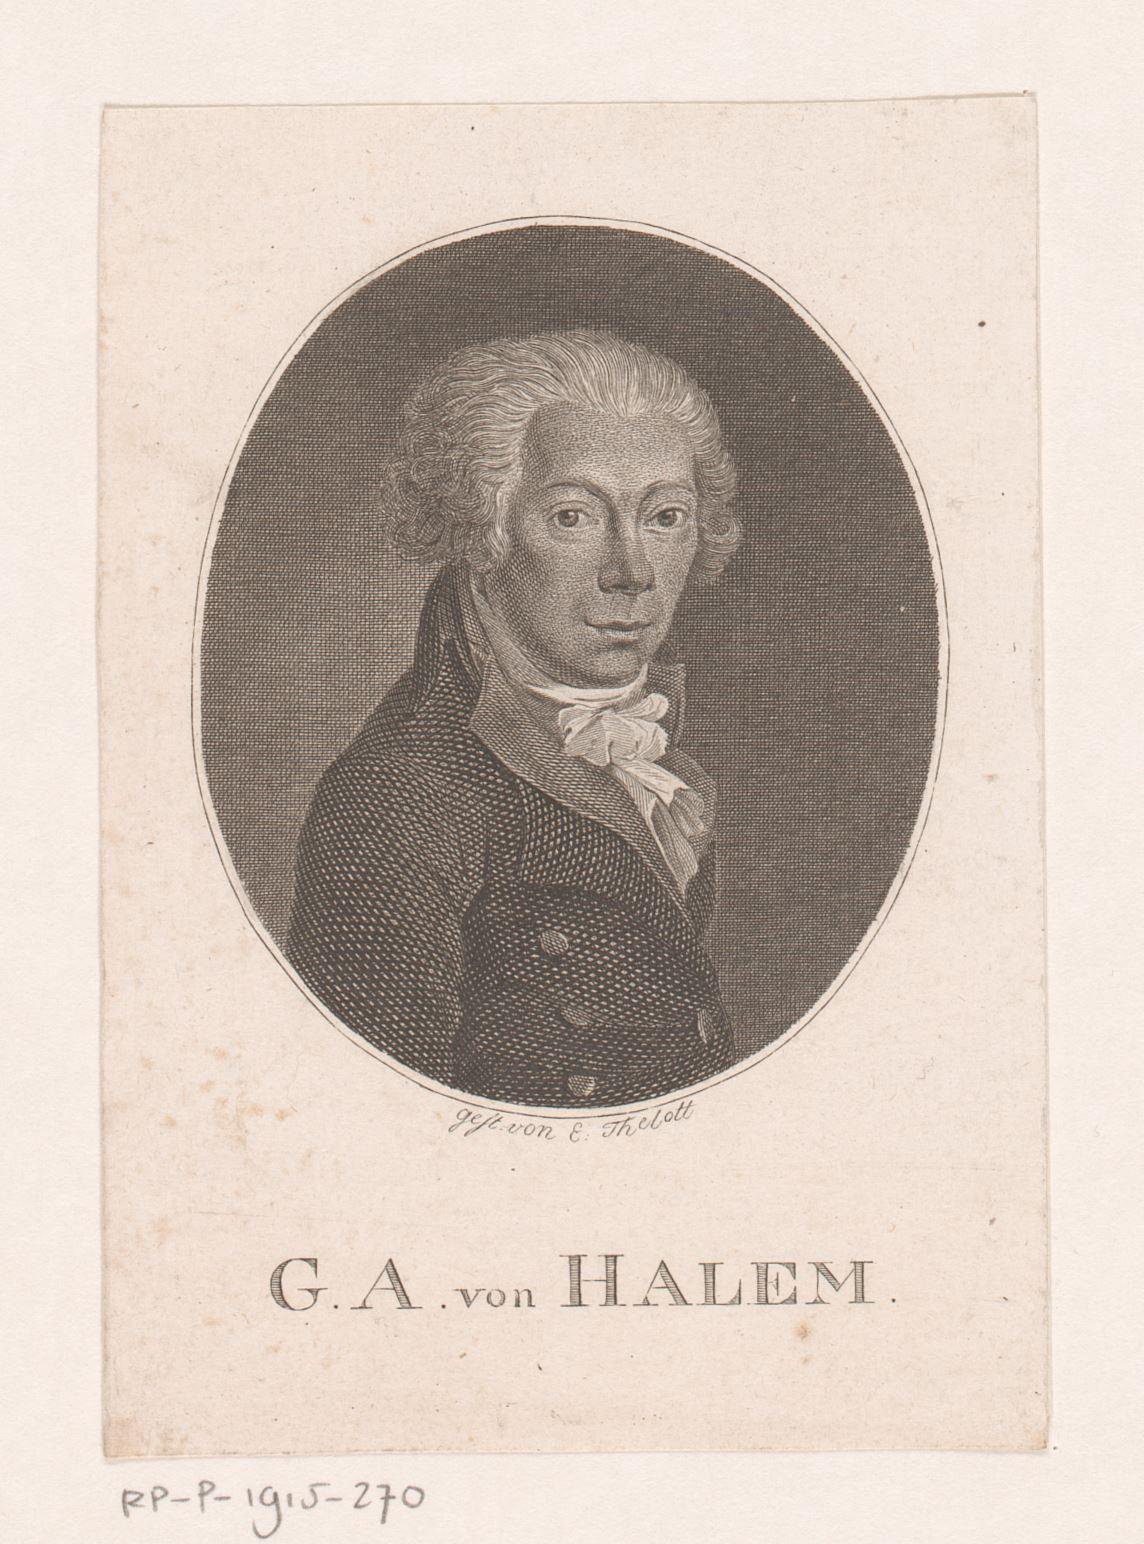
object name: print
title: Portret van Gerhard Anton von Halem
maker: ernst karl gottlieb thelott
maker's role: artist, painter, print maker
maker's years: 1760-1834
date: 1785-1834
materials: paper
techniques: engraving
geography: germany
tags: historical persons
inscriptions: collector's mark: Lugt 2228